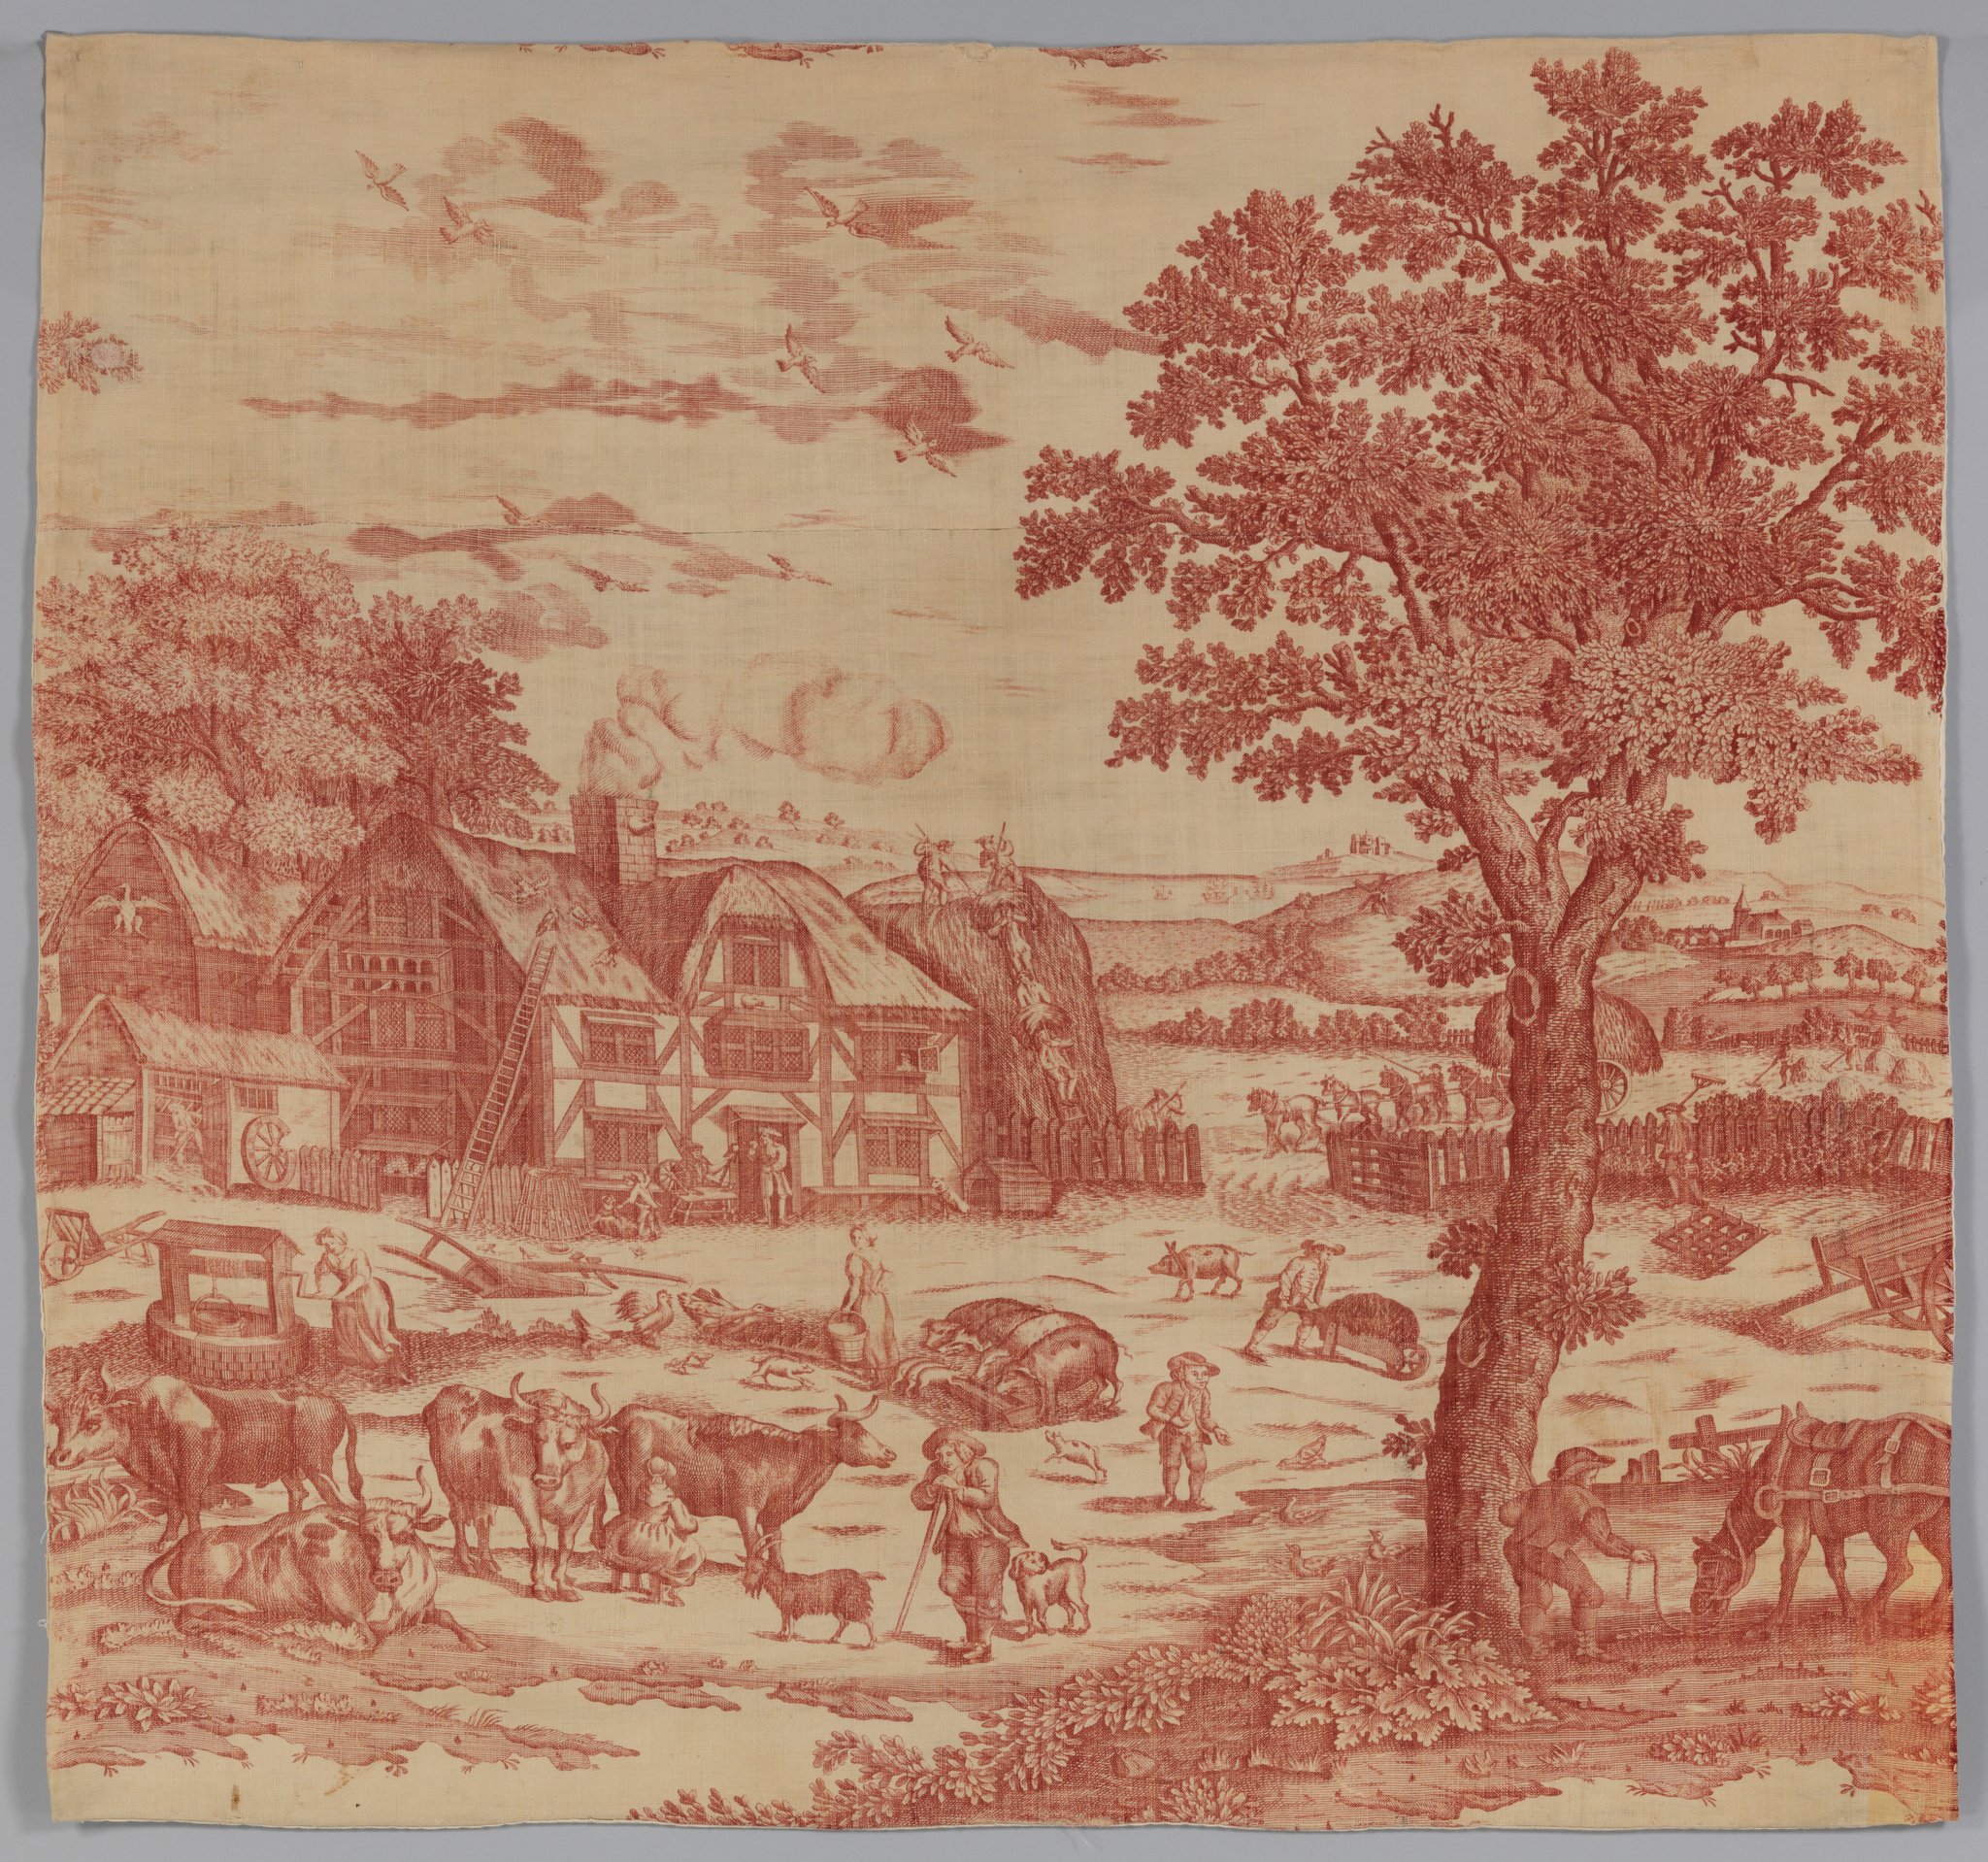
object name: piece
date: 1770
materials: cotton, linen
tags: human figures,houses,cows,trees